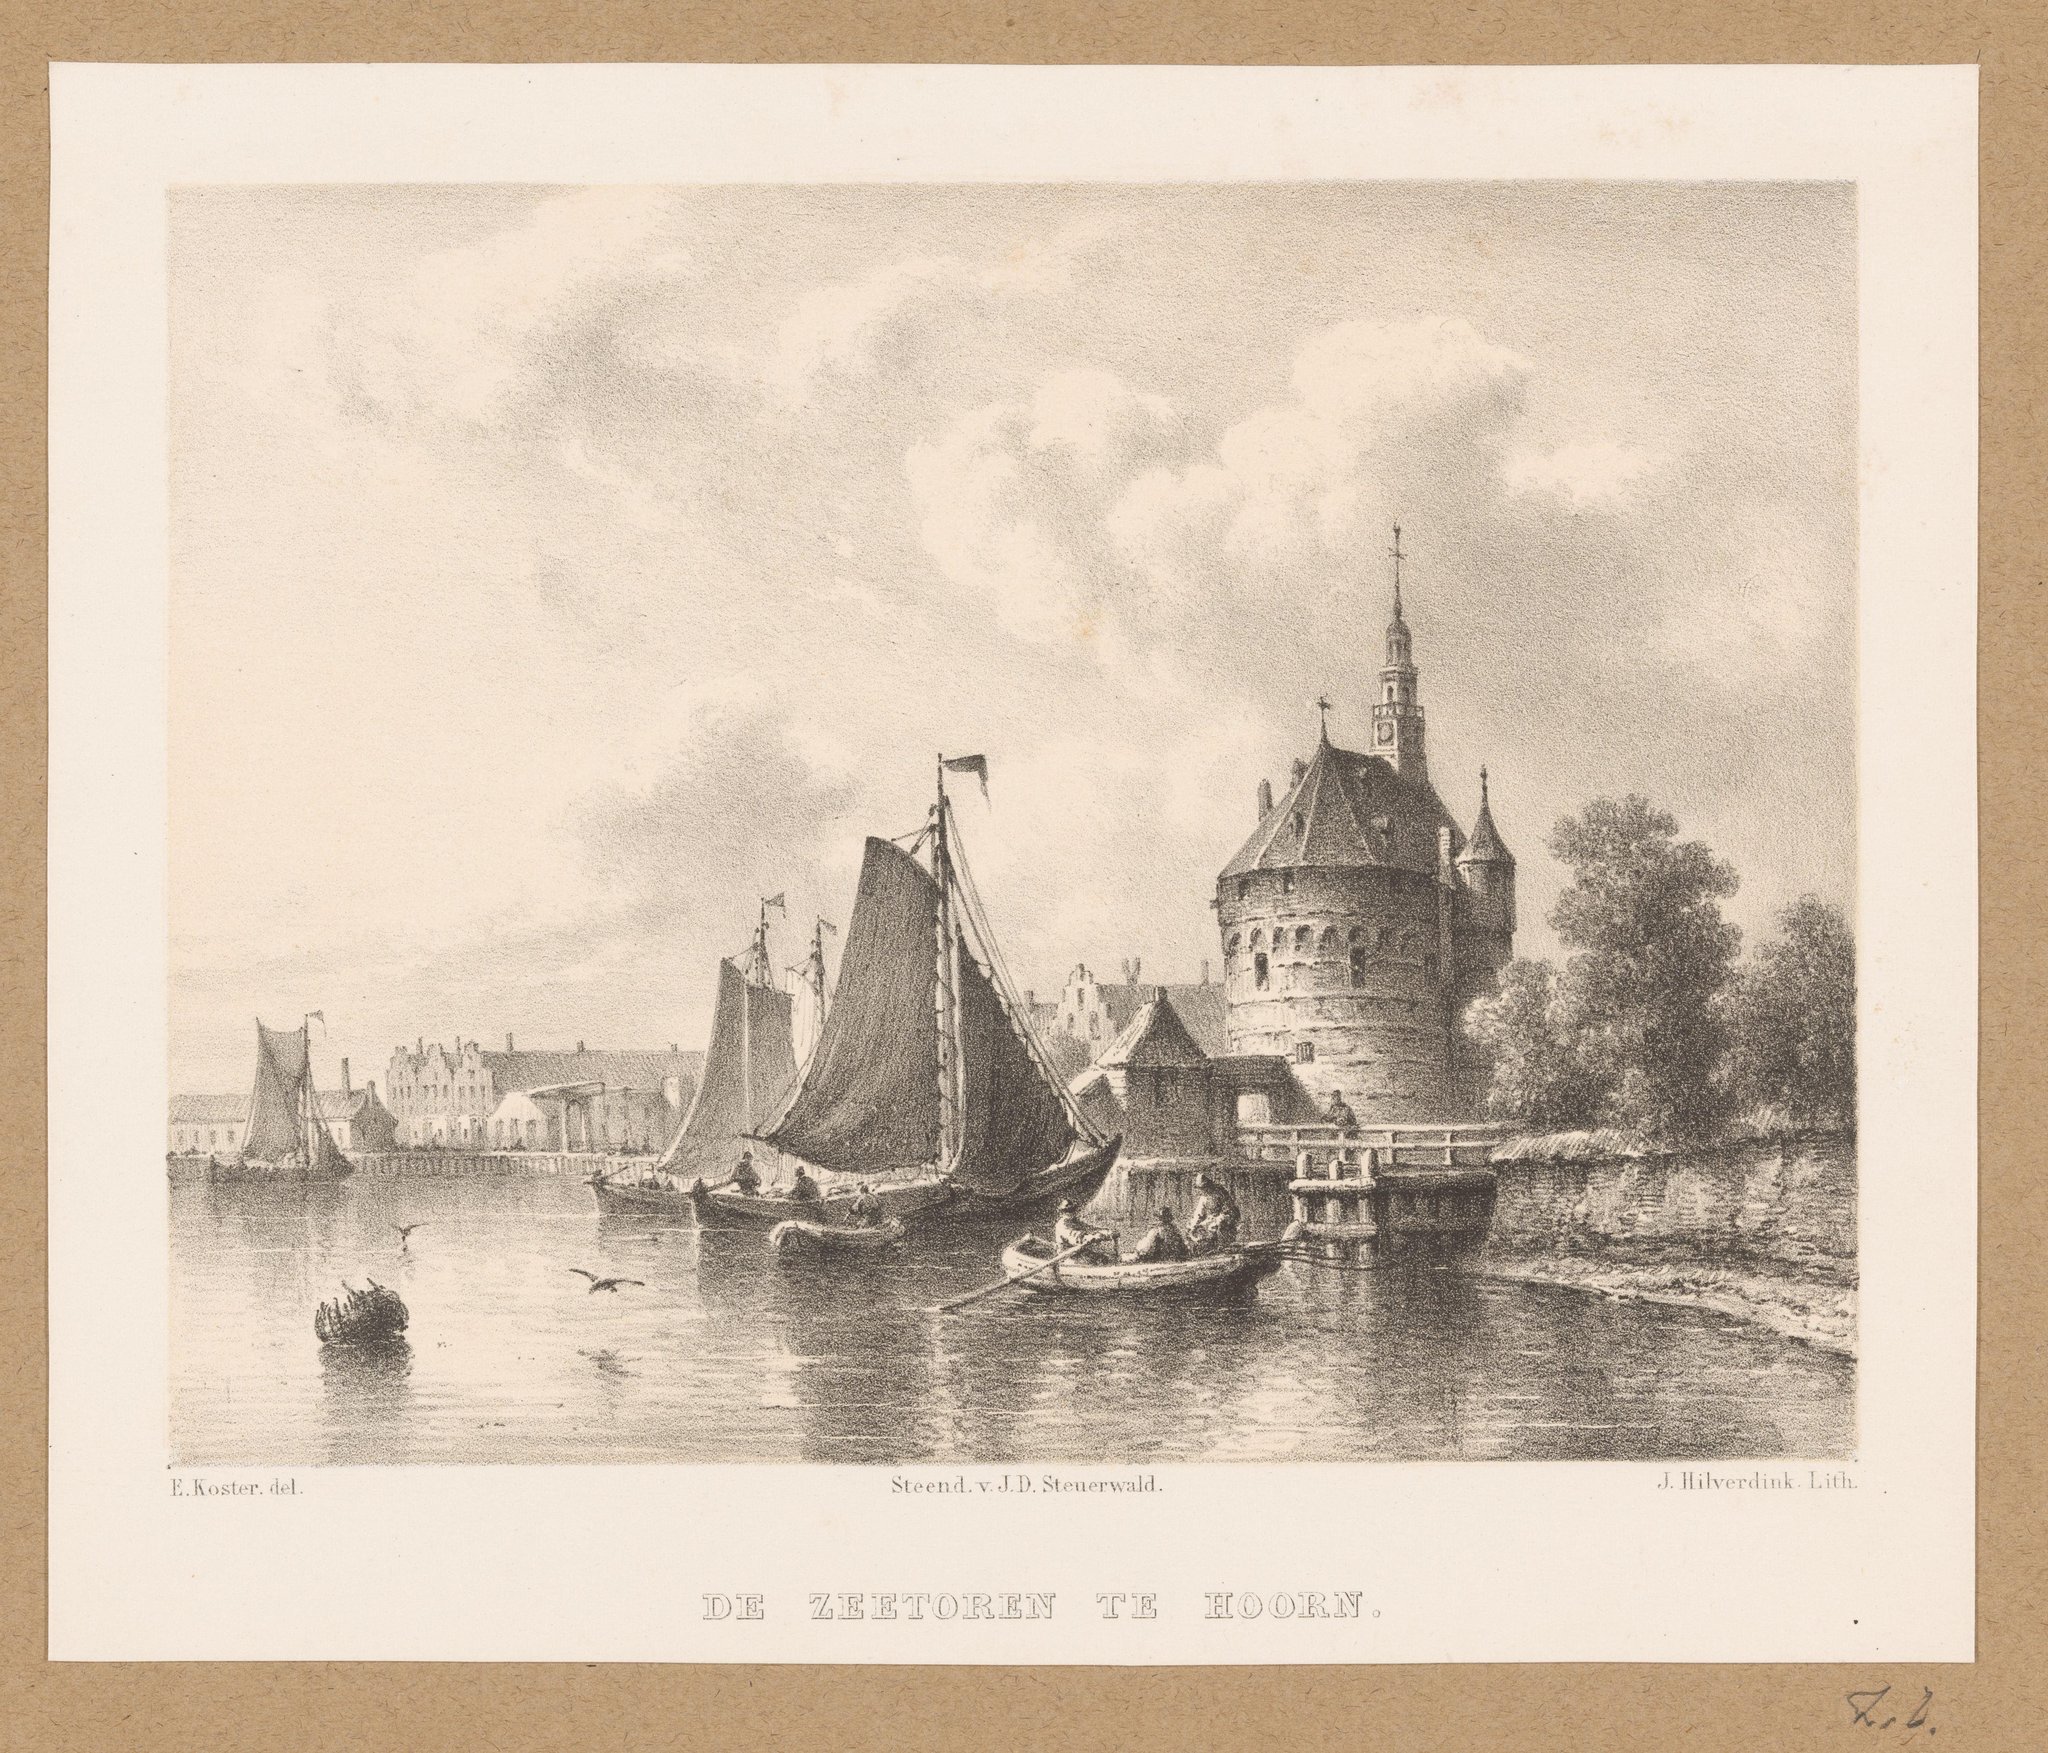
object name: print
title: De Zeetoren te Hoorn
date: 1858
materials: paper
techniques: tone lithography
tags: sailing-ship, sailing-boat, towers ~ fortified city, rowing-boat, canoe, etc., hoorn (north holland)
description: Prent uit: Koster, Everhardus. E. Koster's schetsboek: Nederlandsche Stads- en Havengezichten (...). Amsterdam: Frans Buffa & Zn., 1858.